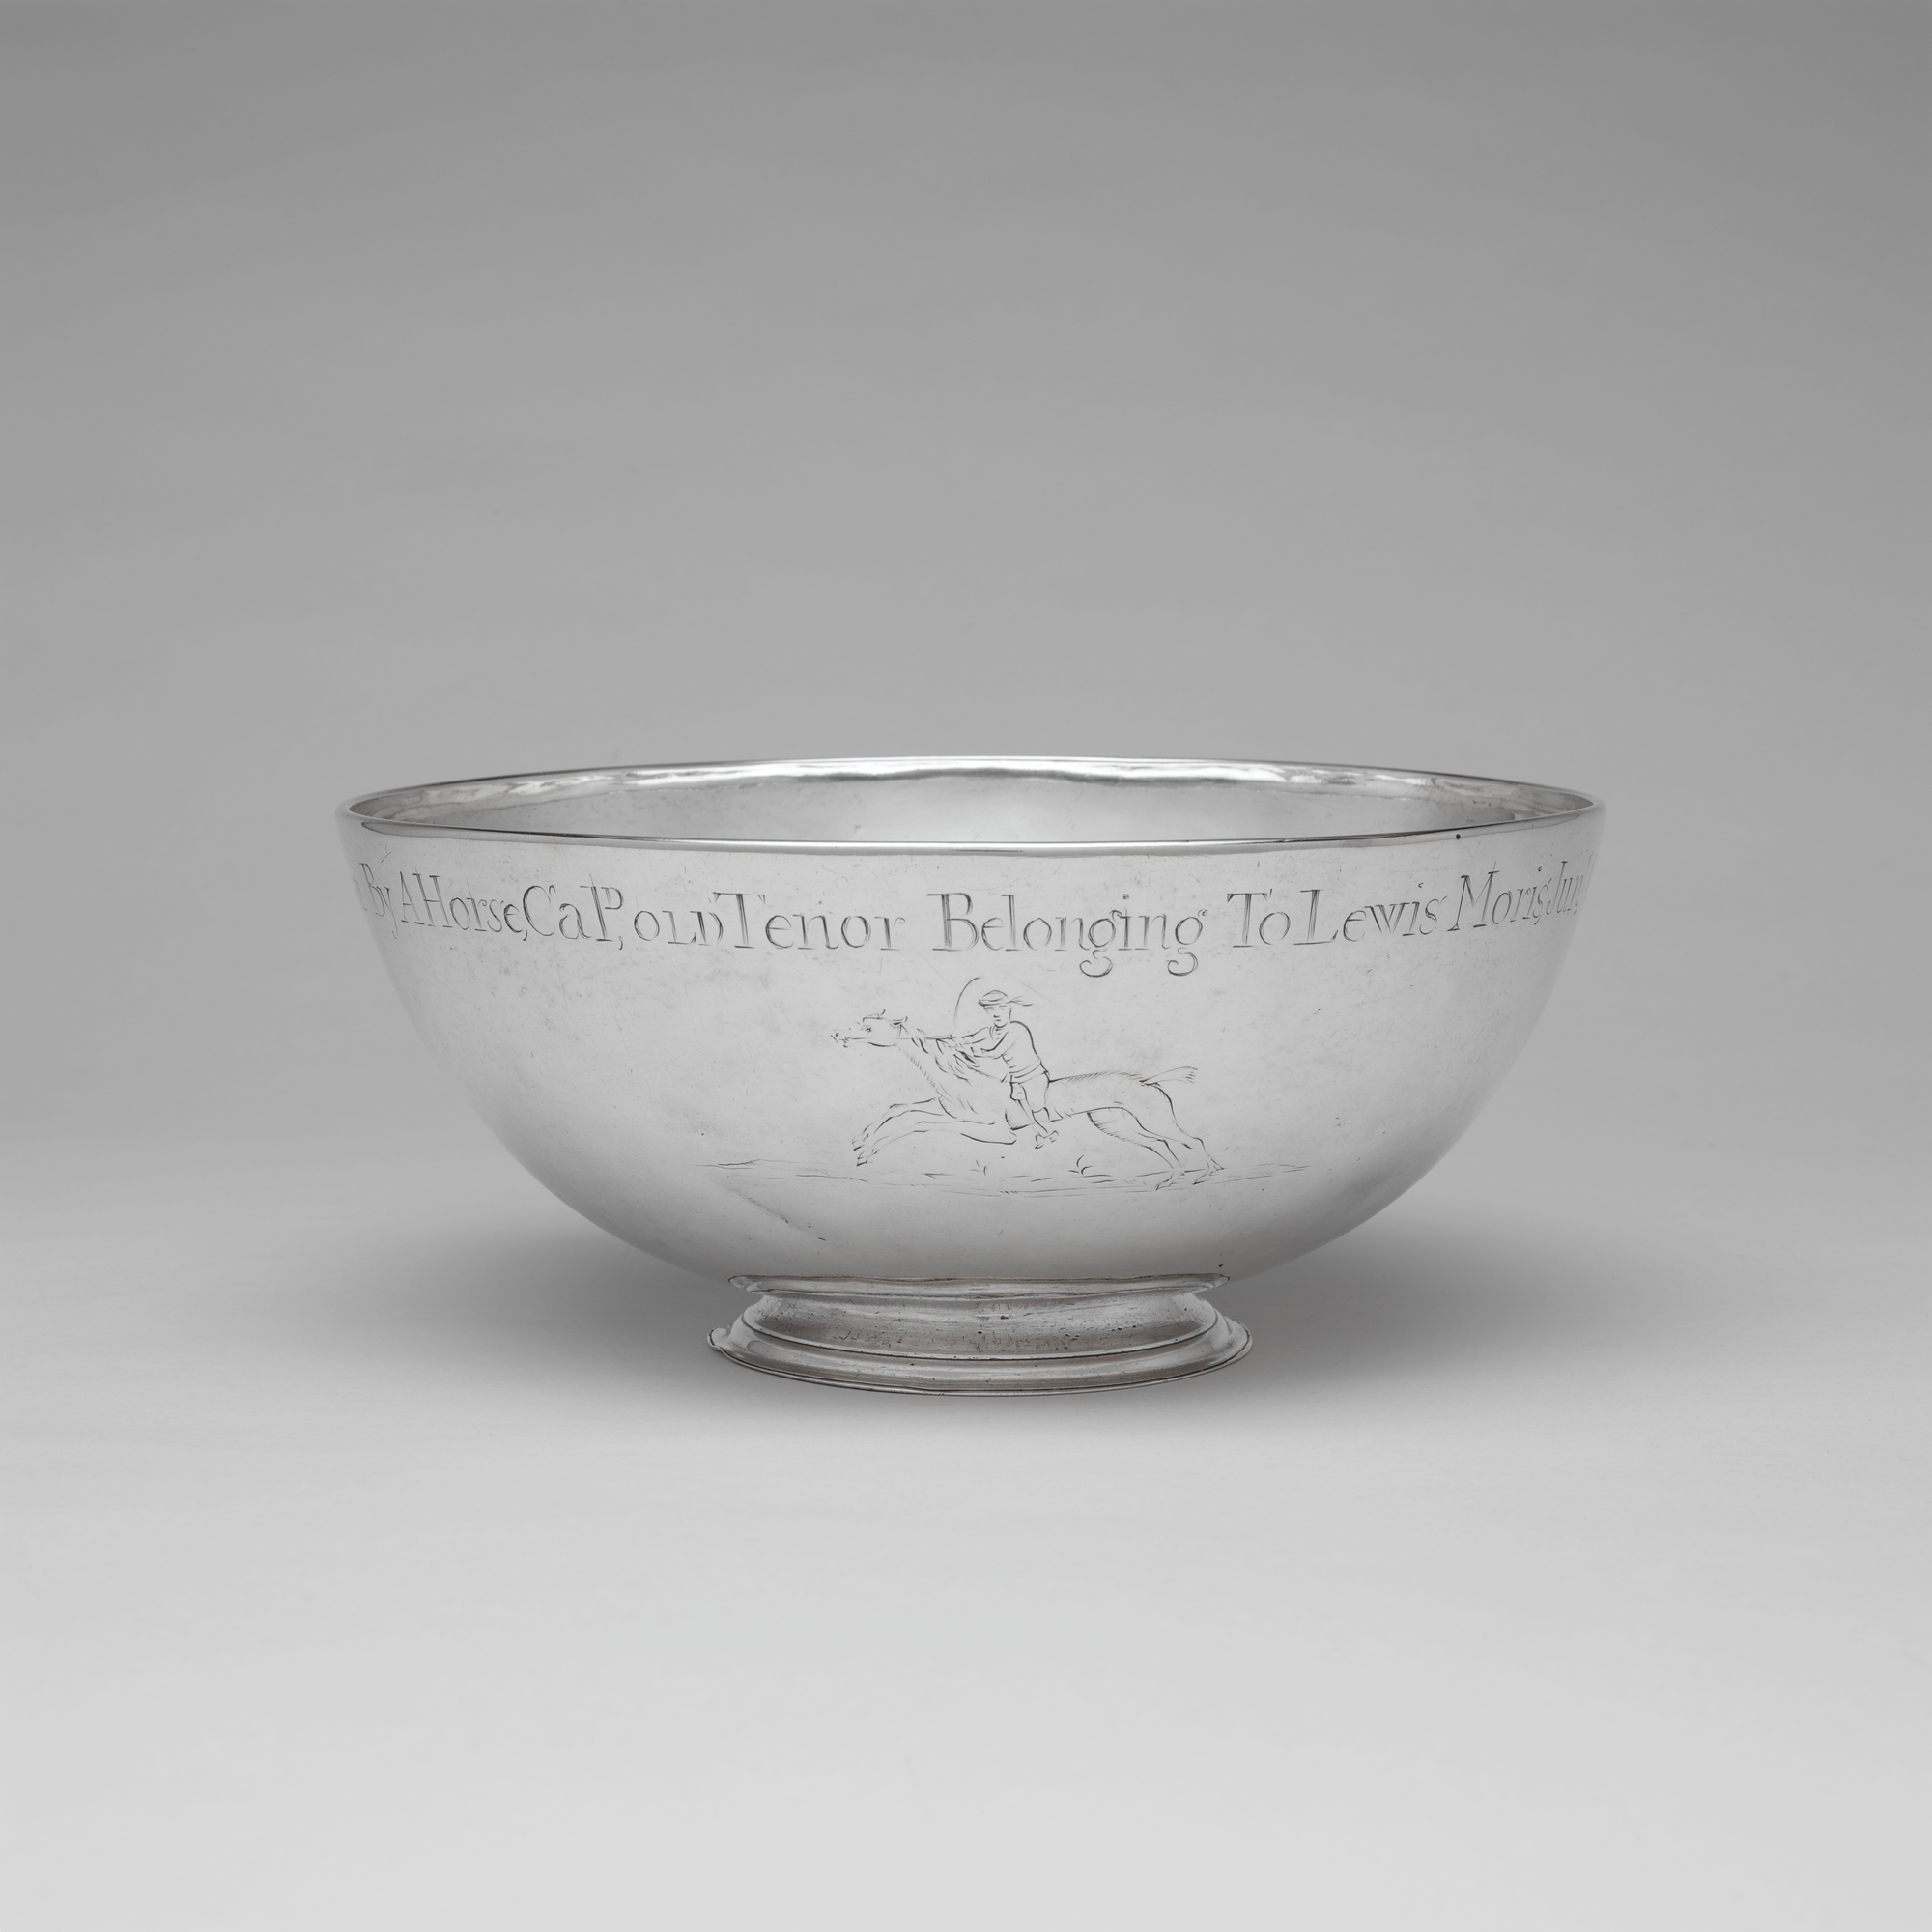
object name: punch bowl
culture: american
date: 1751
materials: silver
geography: united states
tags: horses